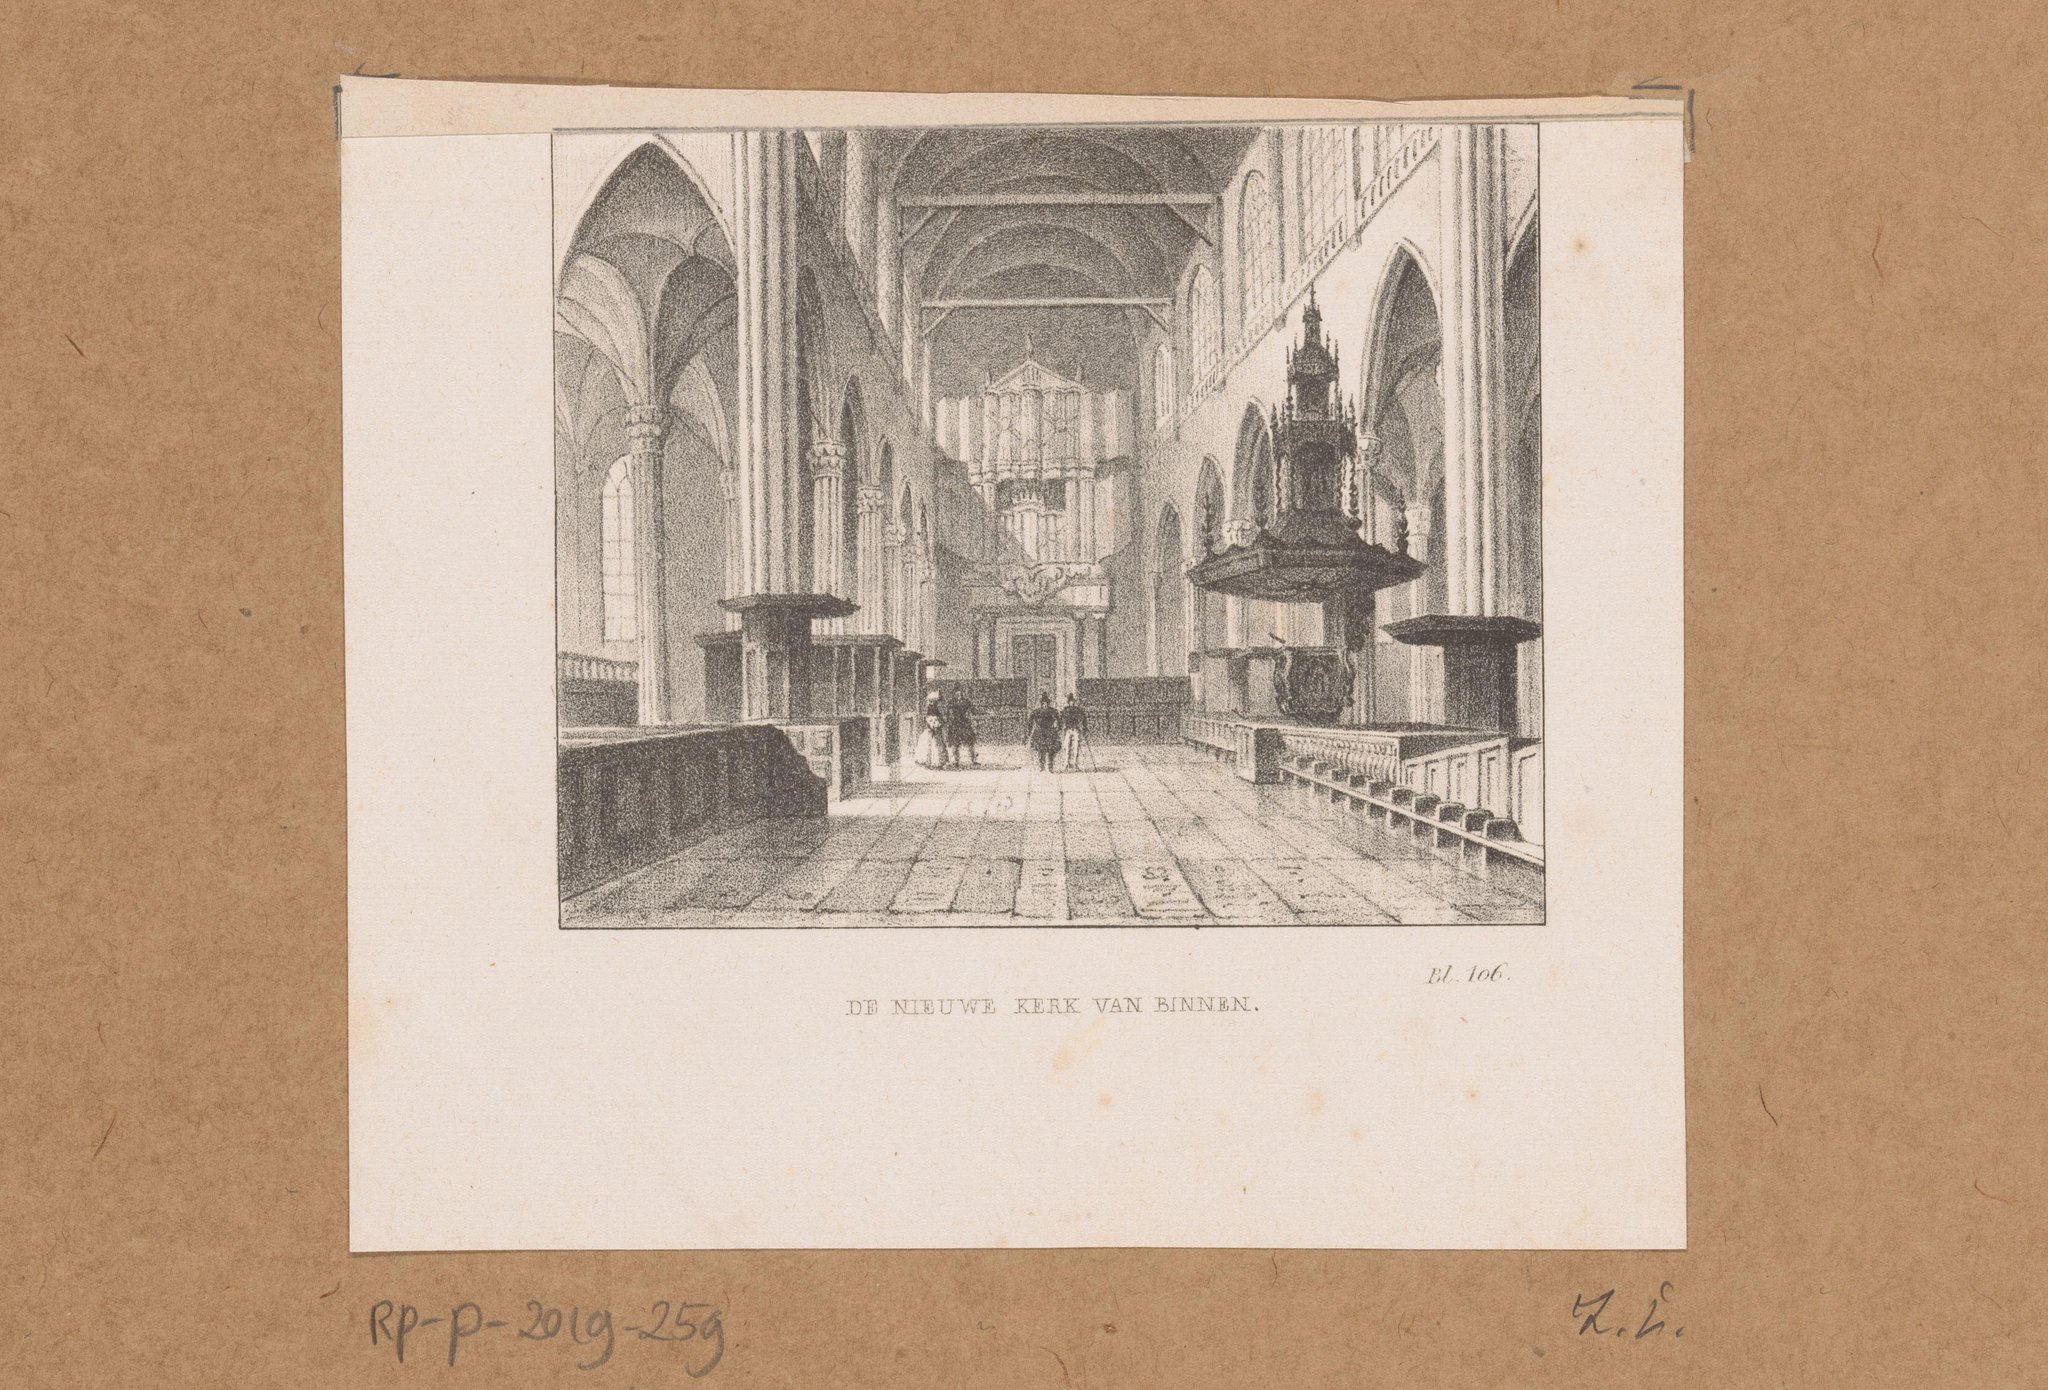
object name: book illustration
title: De Nieuwe Kerk van binnen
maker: johannes hilverdink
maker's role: draughtsman, painter, print maker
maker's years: 1813-1902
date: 1844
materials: paper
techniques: lithograph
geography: amsterdam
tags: interior of church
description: Prent uit: Vijver, C. van der. Geschiedkundige beschrijving der stad Amsterdam. Amsterdam: Gebroeders Diederichs, 1844, dl. 1, p. 106.